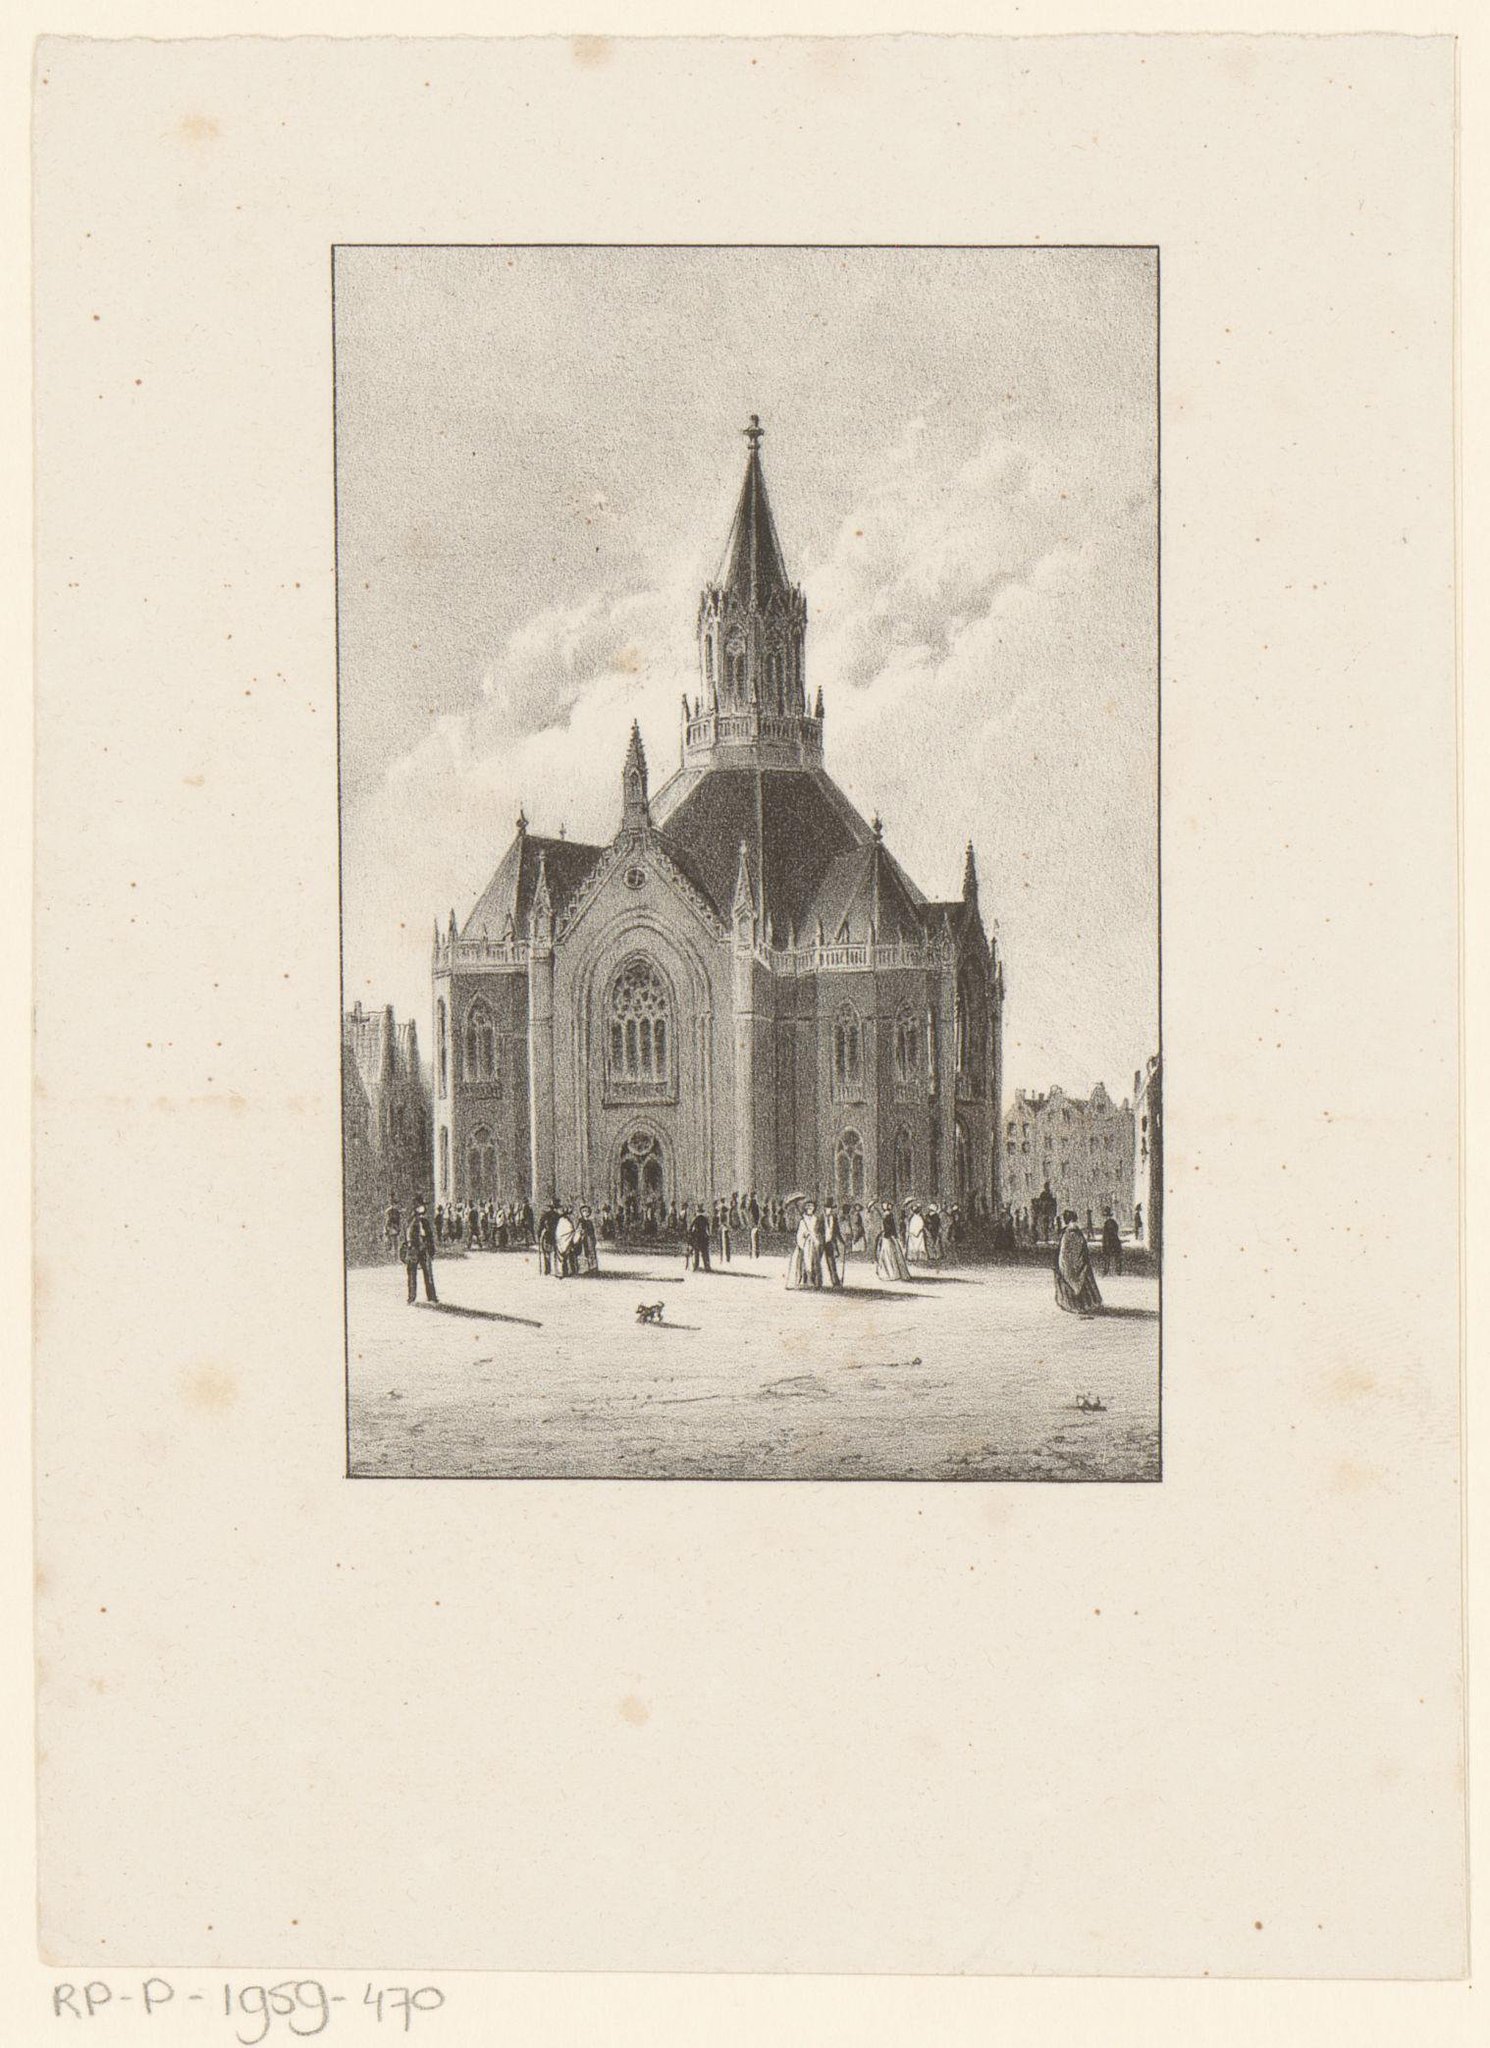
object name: print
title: Nieuwe Kerk te Den Haag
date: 1832-1880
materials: paper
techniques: lithograph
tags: church (exterior)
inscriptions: collector's mark: Lugt 2228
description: Mensen op het plein voor de Nieuwe Kerk.